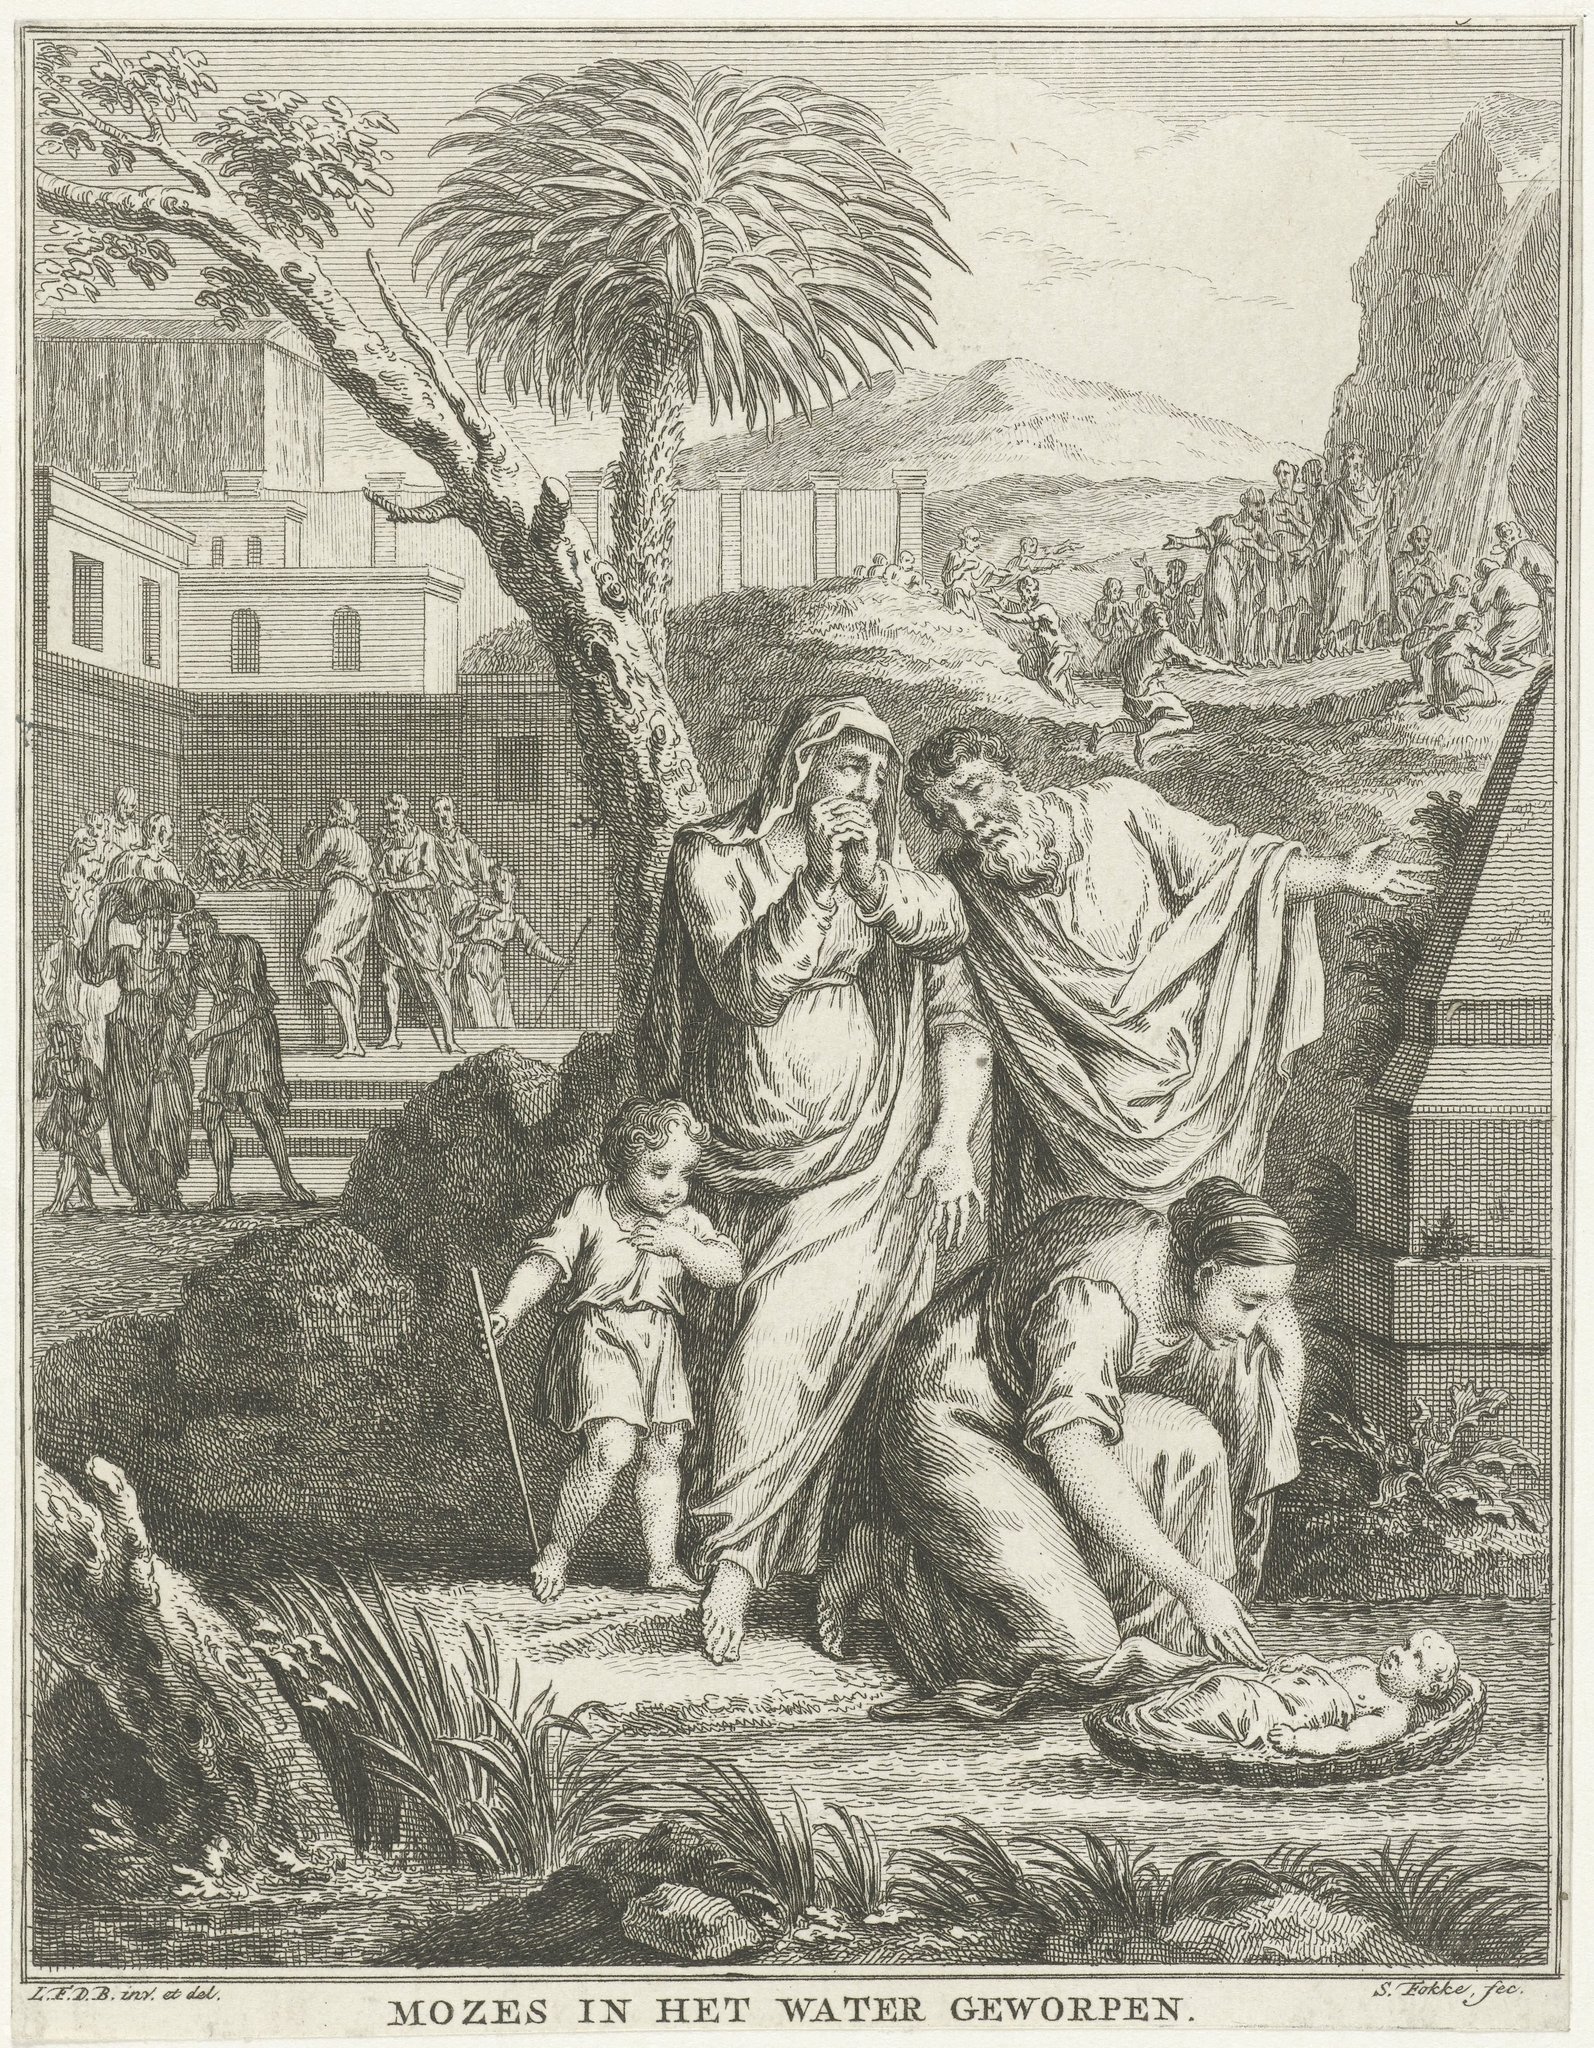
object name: print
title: Mozes in het water geworpen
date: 1722-1784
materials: paper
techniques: etching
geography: amsterdam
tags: jochebed makes an ark (or basket) of bulrushes daubed with pitch and puts moses in it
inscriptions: collector's mark: Lugt 2228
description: Mozes wordt onder toeziend oog van zijn ouders Amram en Jochebed en zijn broer Aäron in een biezen mand in de Nijl gelegd. Op de achtergrond zicht op Egypte met haar inwoners.